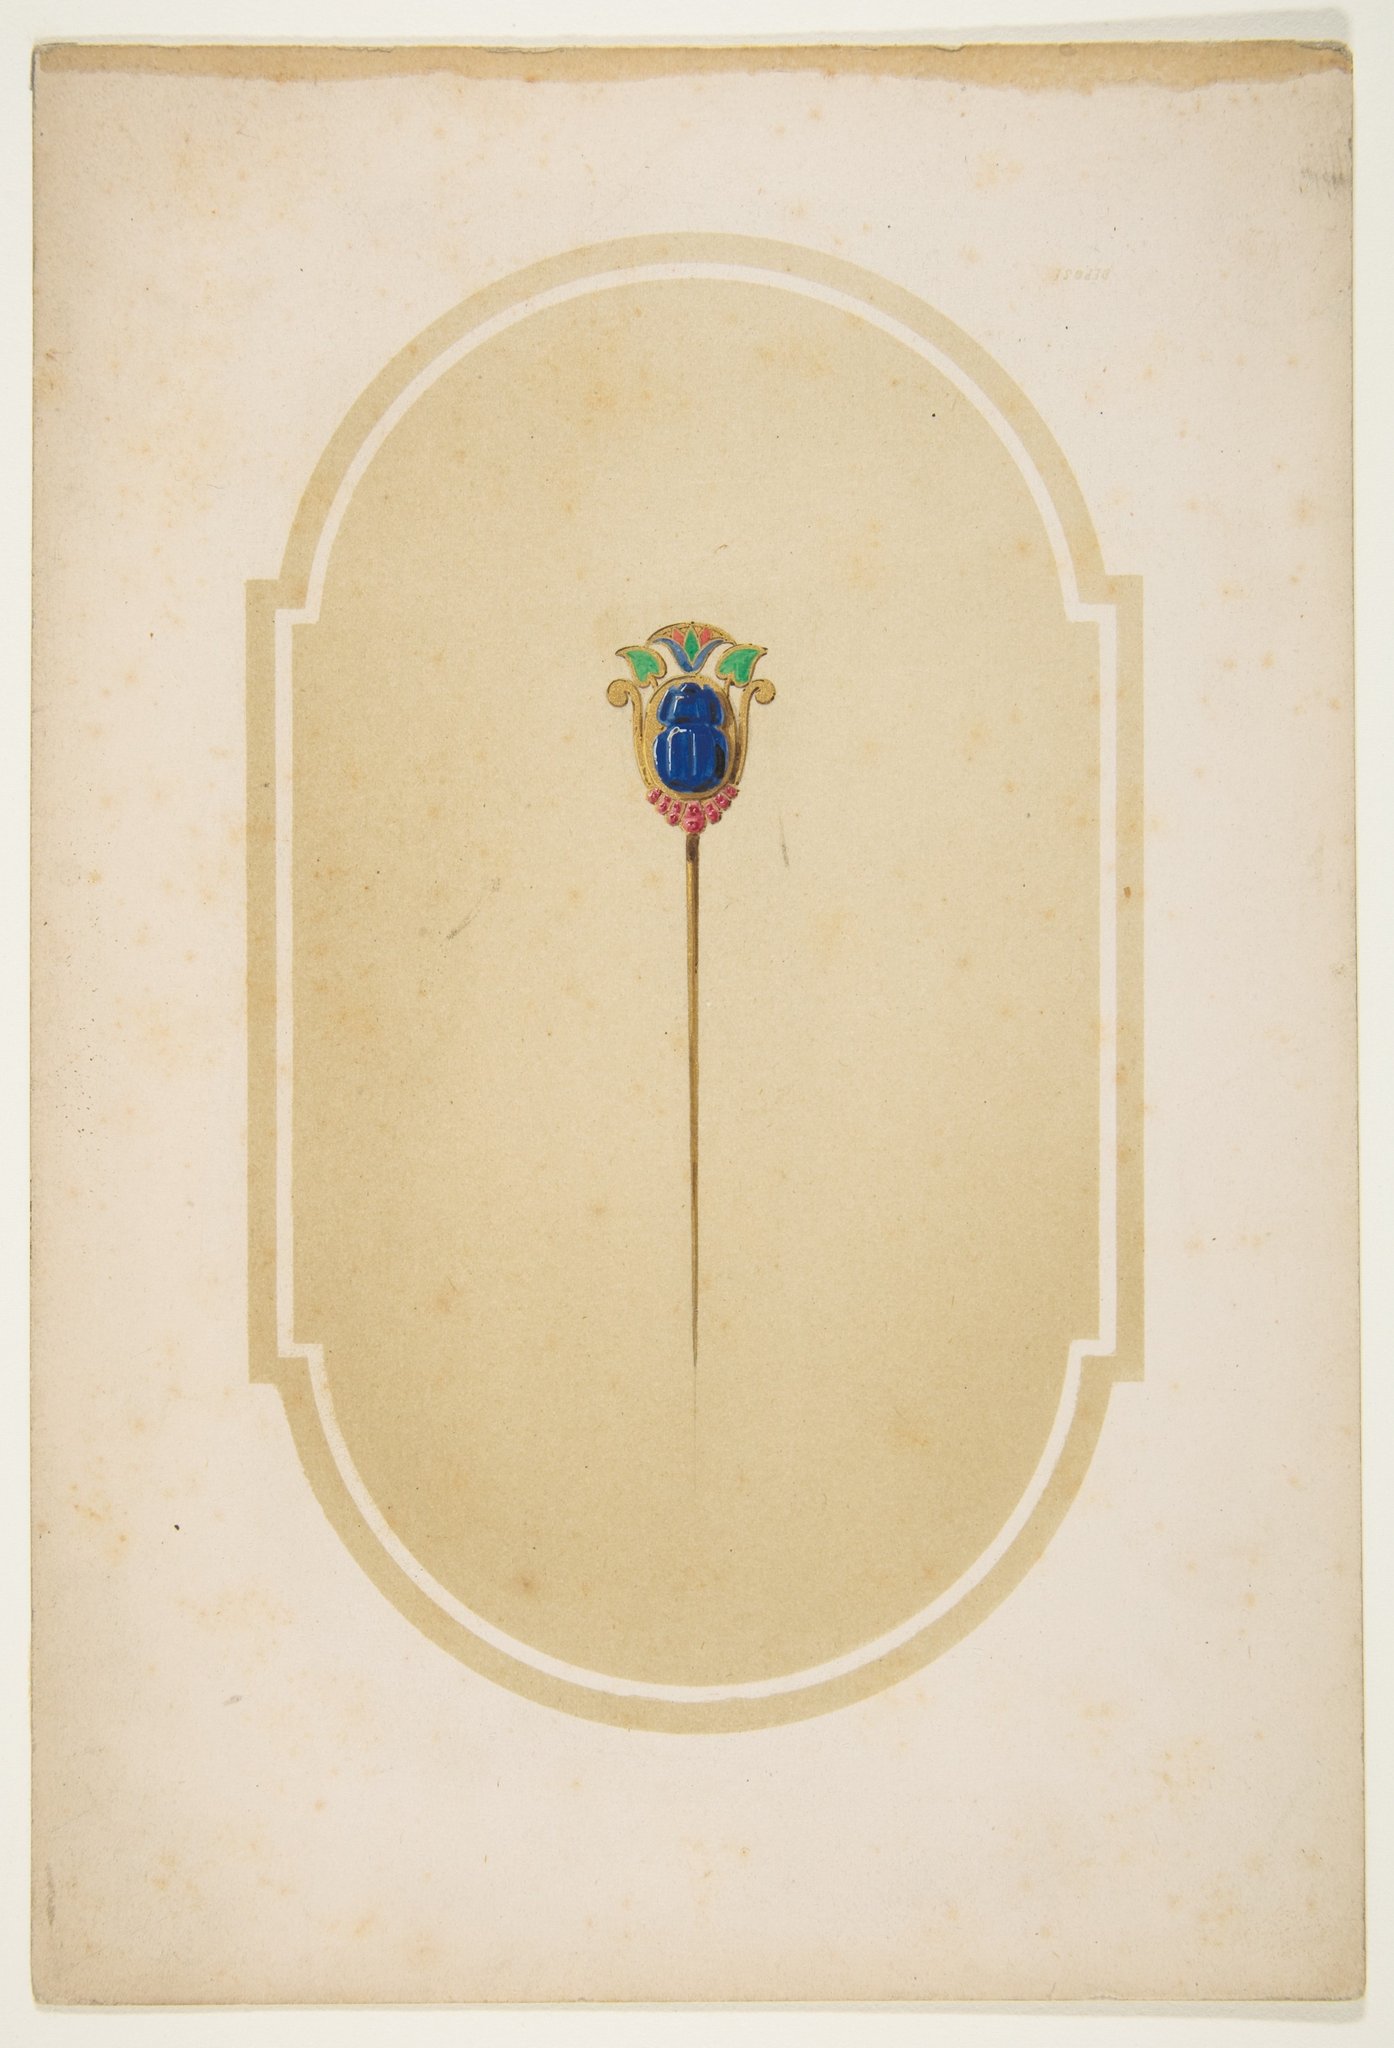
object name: drawing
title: Design for a pin with a blue scarab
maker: anonymous, french, 19th century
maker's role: artist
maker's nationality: french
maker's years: 1800-1900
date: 1801-1900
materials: cardboard, ink, watercolor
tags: pins,scarabs